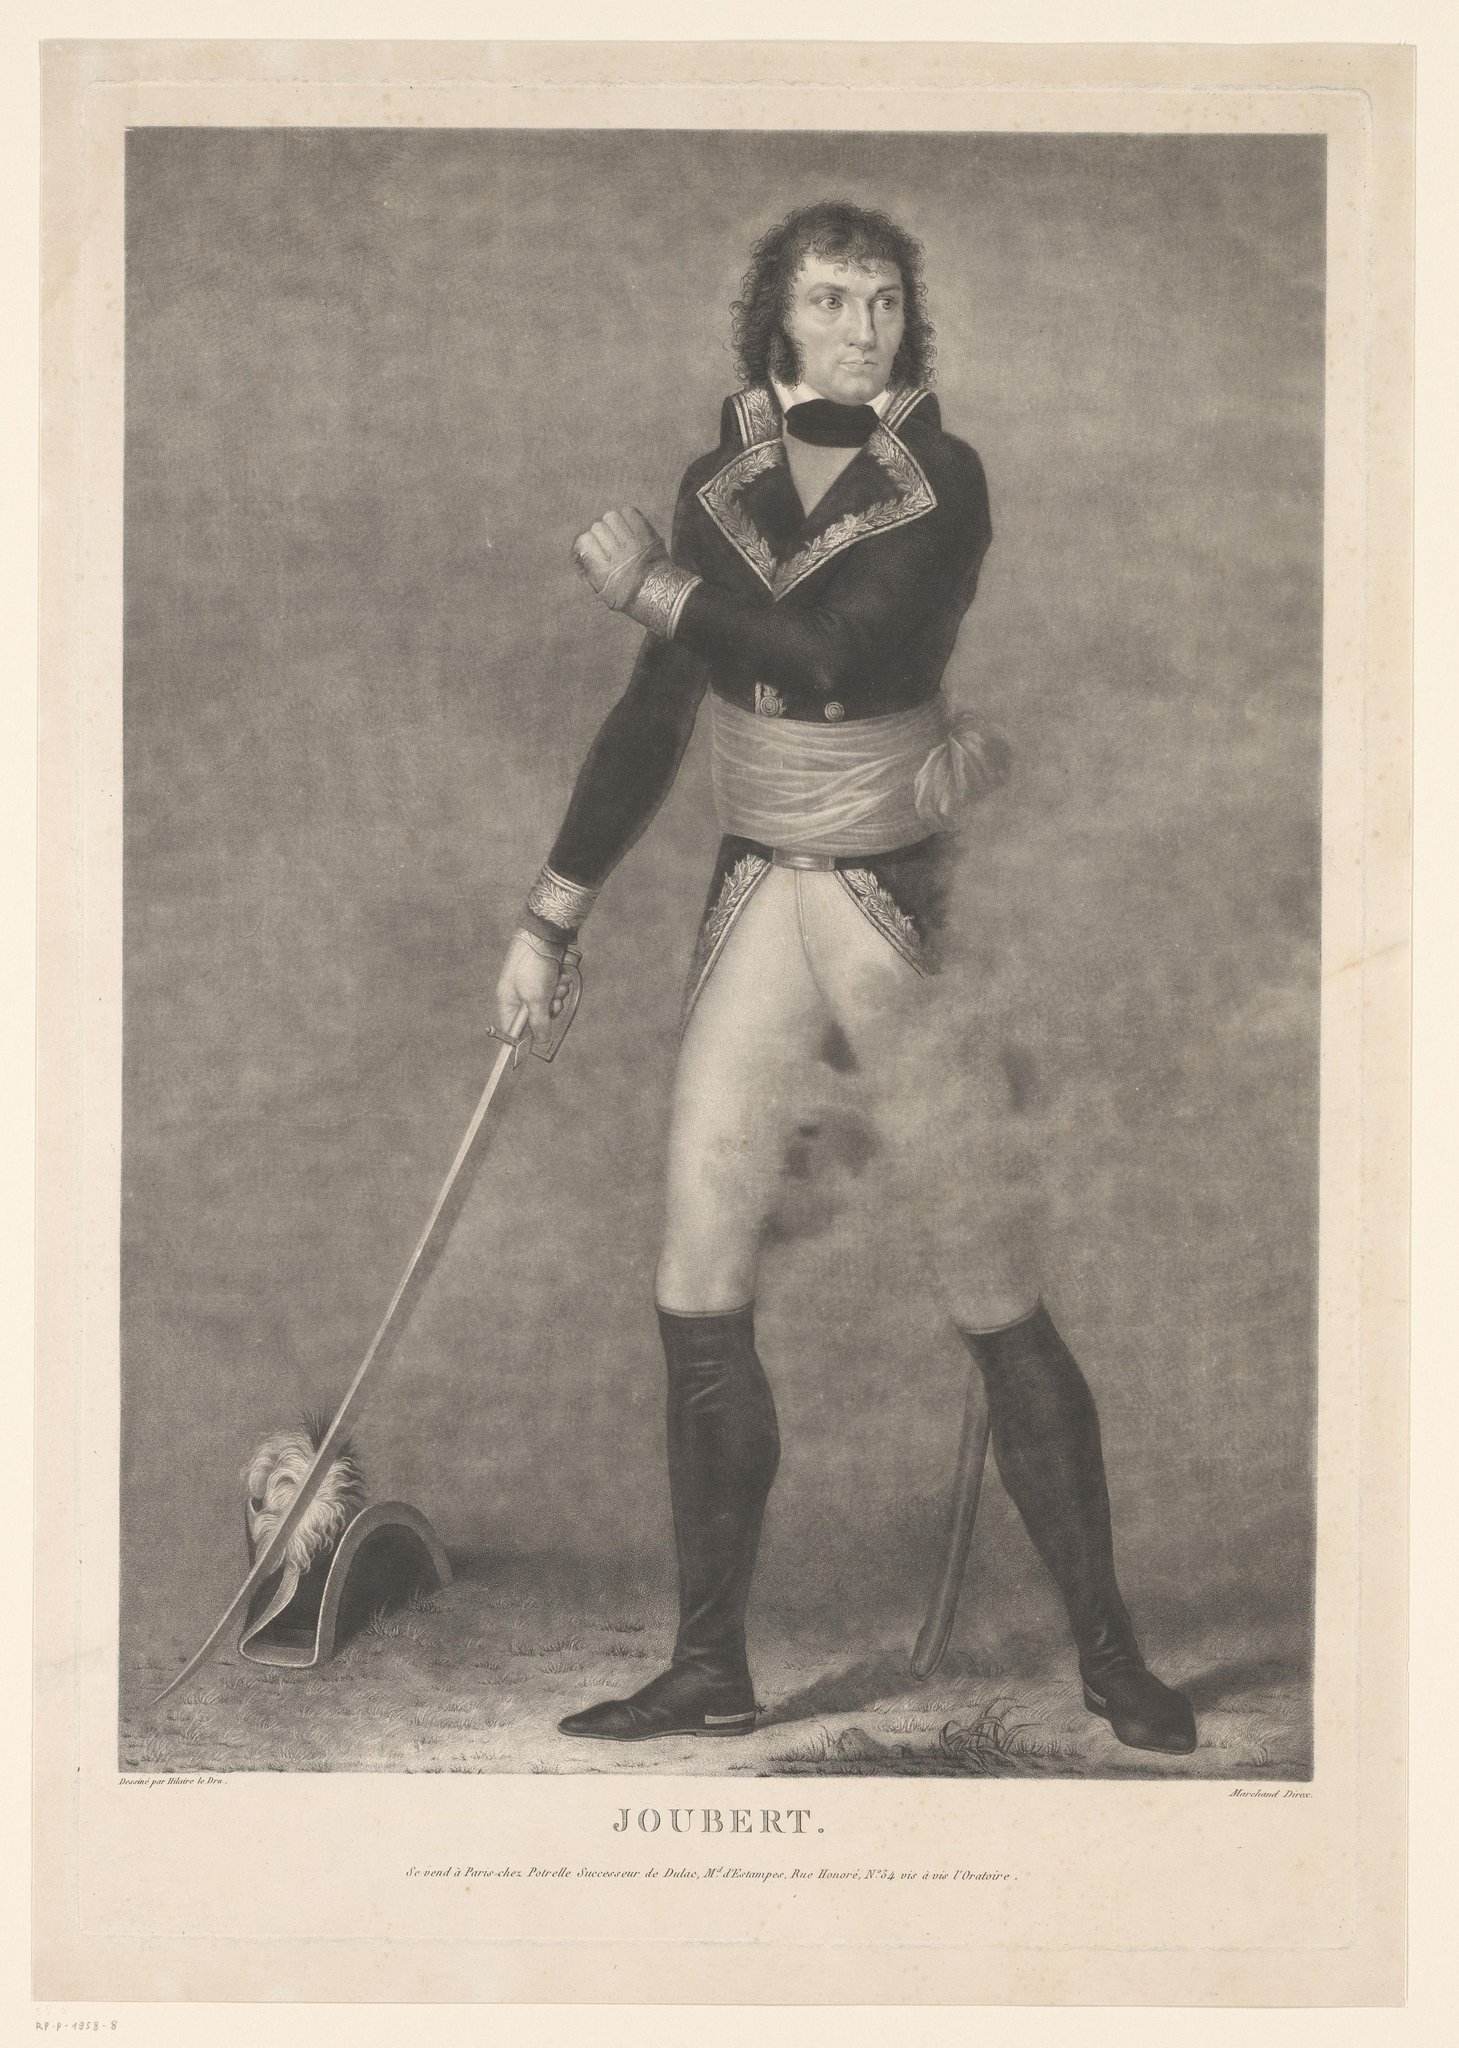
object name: print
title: Joubert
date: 1779-1845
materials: paper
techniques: aquatint, engraving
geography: paris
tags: commander-in-chief, general, marshal, historical persons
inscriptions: collector's mark: Lugt 2228